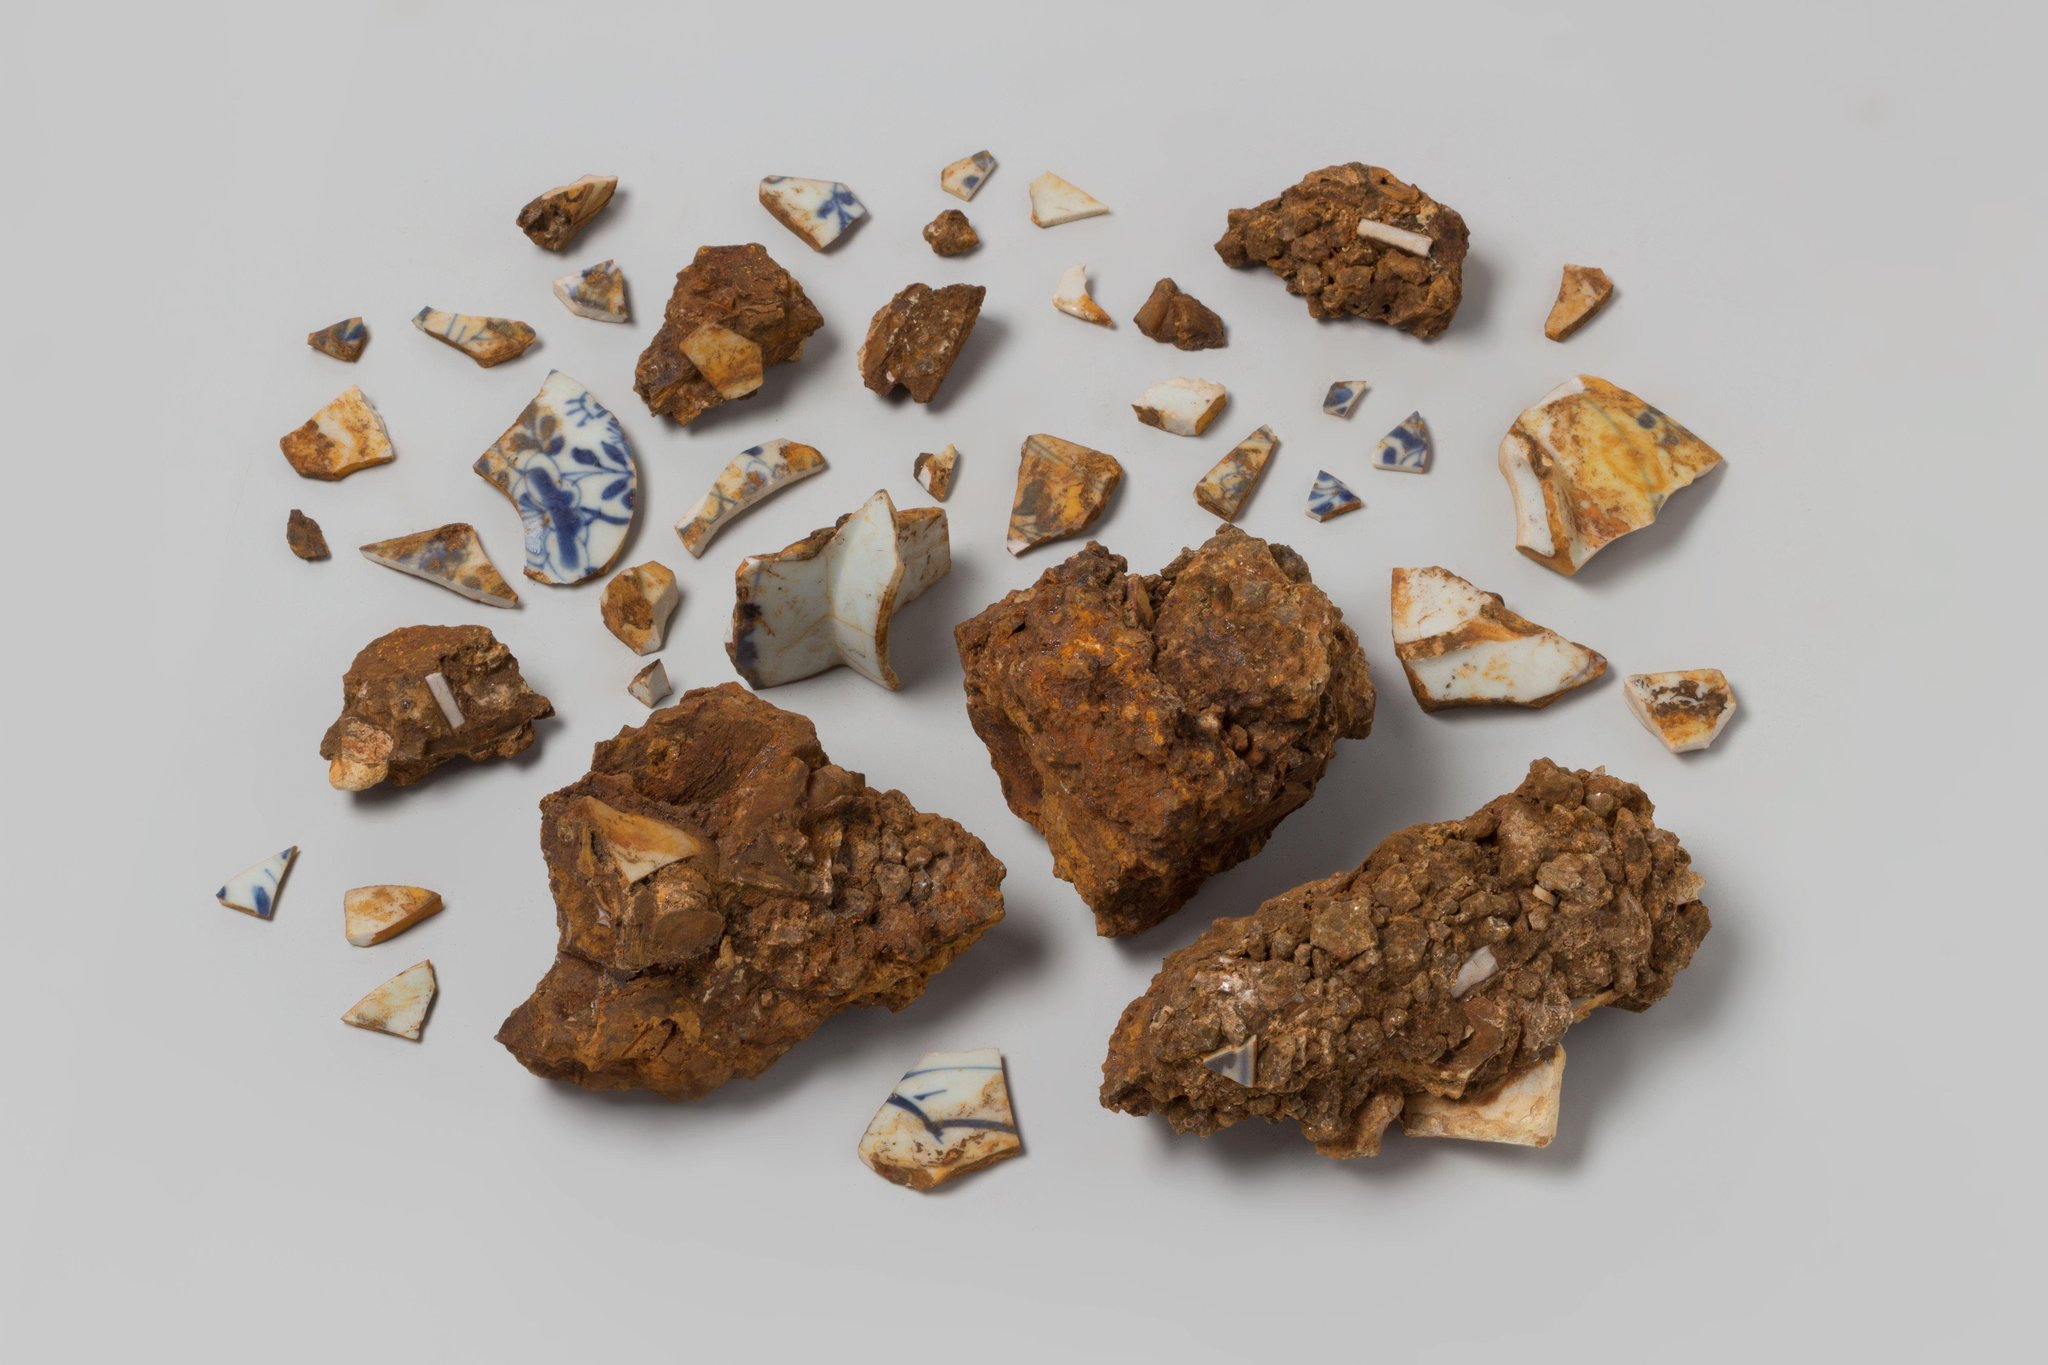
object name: sherd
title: Brokken concretie met fragmenten van kommen uit het wrak van de Oost-Indiëvaarder Hollandia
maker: Anonymous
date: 1700-1743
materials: stone, porcelain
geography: netherlands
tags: verenigde oostindische compagnie, hollandia (schip), annet